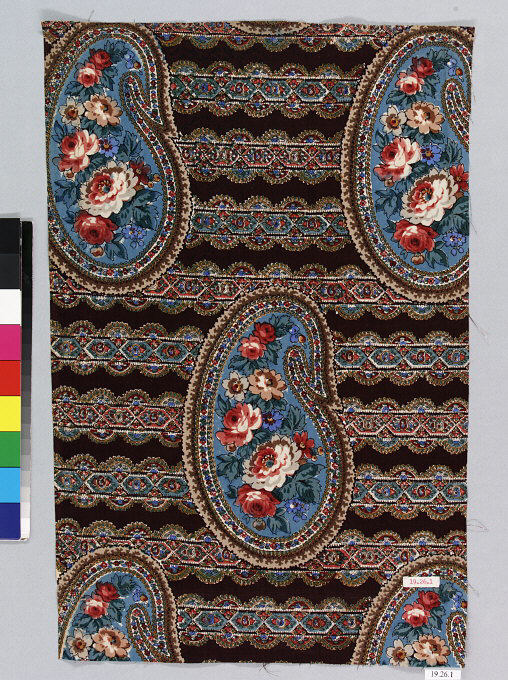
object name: sample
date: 1840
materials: cotton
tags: roses